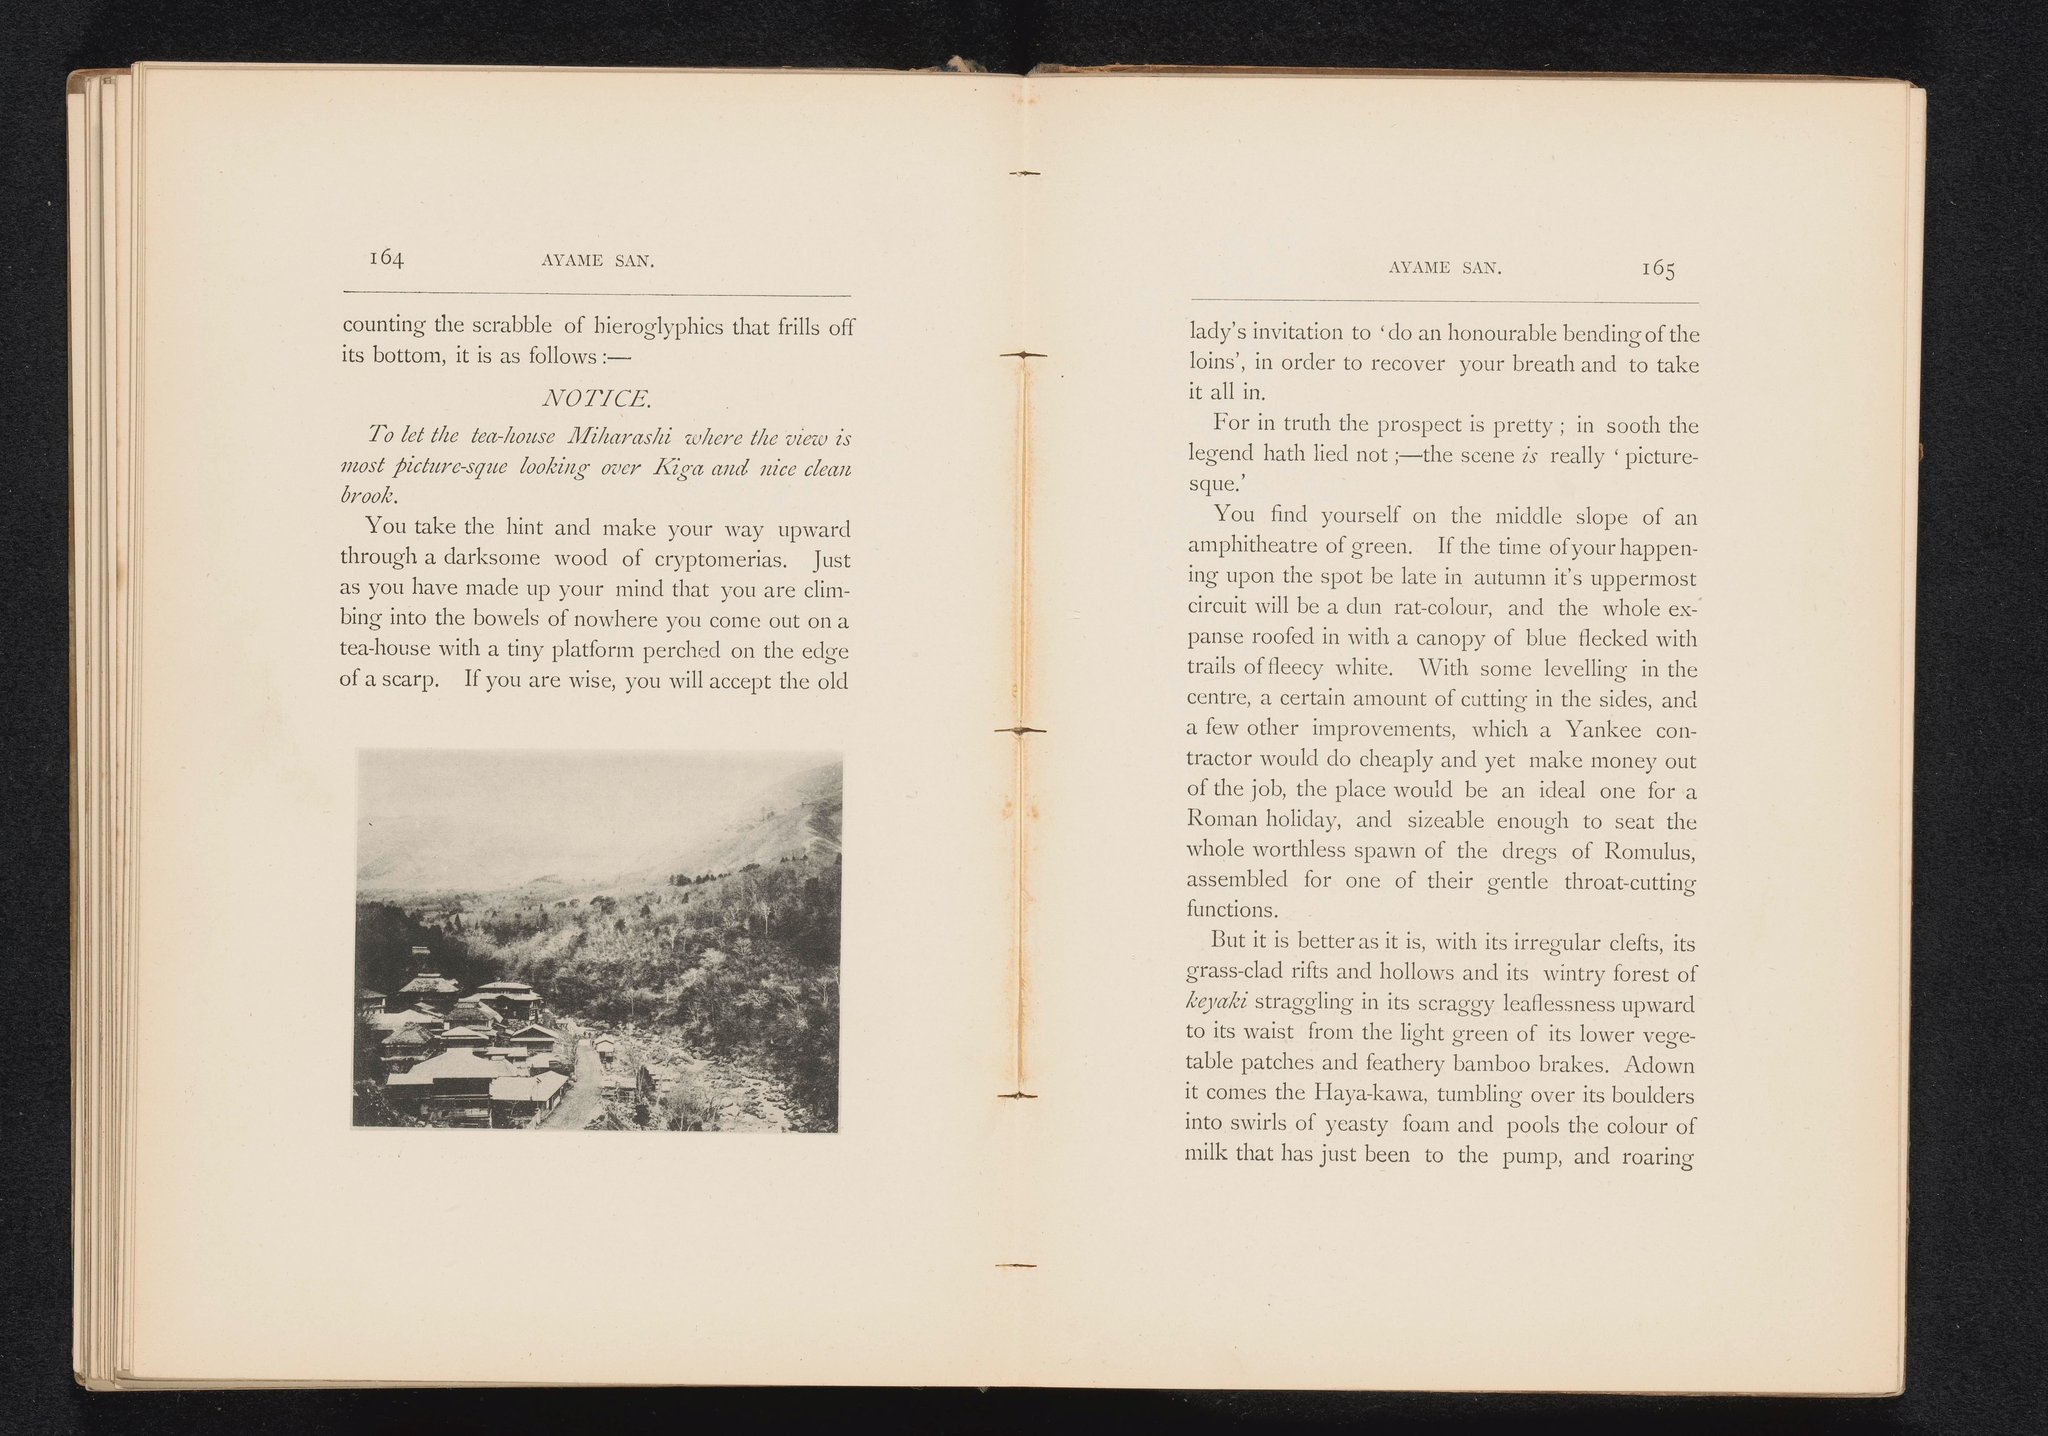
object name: page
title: Gezicht op (vermoedelijk) de Hayakawavallei te Japan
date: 1882-1892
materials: paper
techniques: photograph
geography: japan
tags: dale, valley